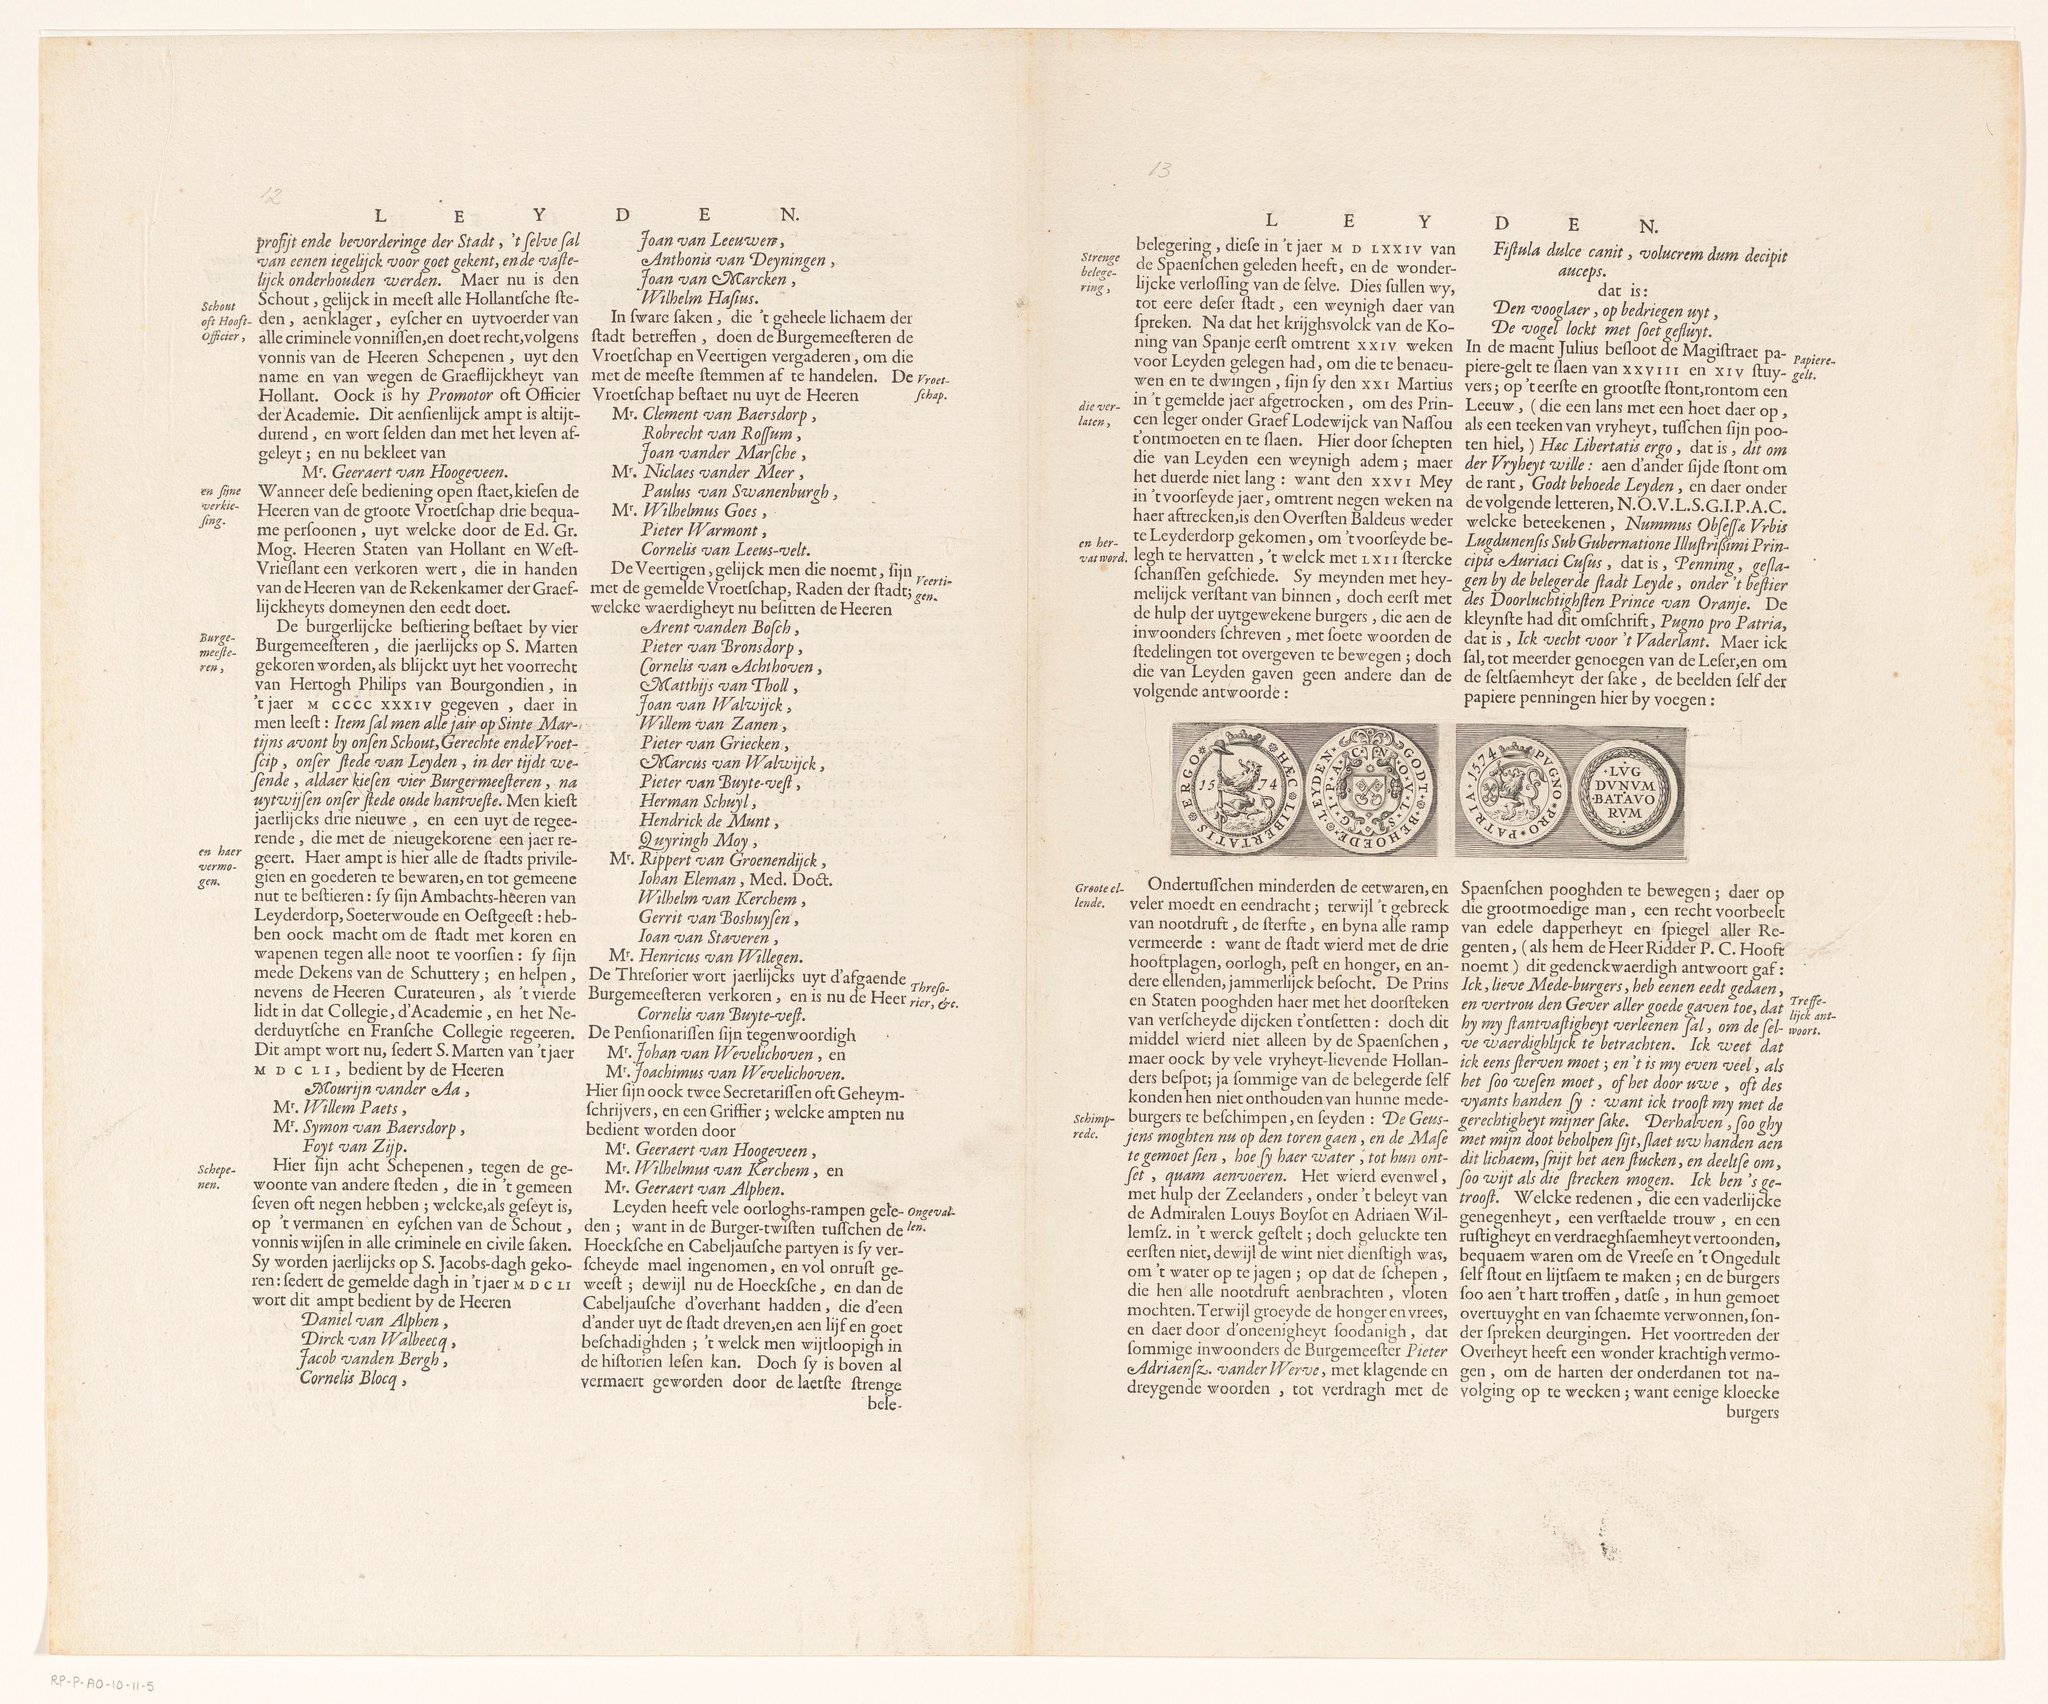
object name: text sheet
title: Leyden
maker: johannes willemszoon blaeu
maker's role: printer, publisher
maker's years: 1596-1673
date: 1652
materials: paper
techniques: letterpress printing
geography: amsterdam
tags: coat of arms (as symbol of the state, etc.) (+ city; municipal), leiden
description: Tekst gebruikt in: Blaeu, Johannes Willemszoon. Toonneel der steden van de Vereenighde Nederlanden. 2 delen. Amsterdam: Johannes Willemszoon Blaeu, 1652, dl. 1. Zie ook RP-P-AO-10-11-2, RP-P-AO-10-11-3 en RP-P-AO-10-11-4.